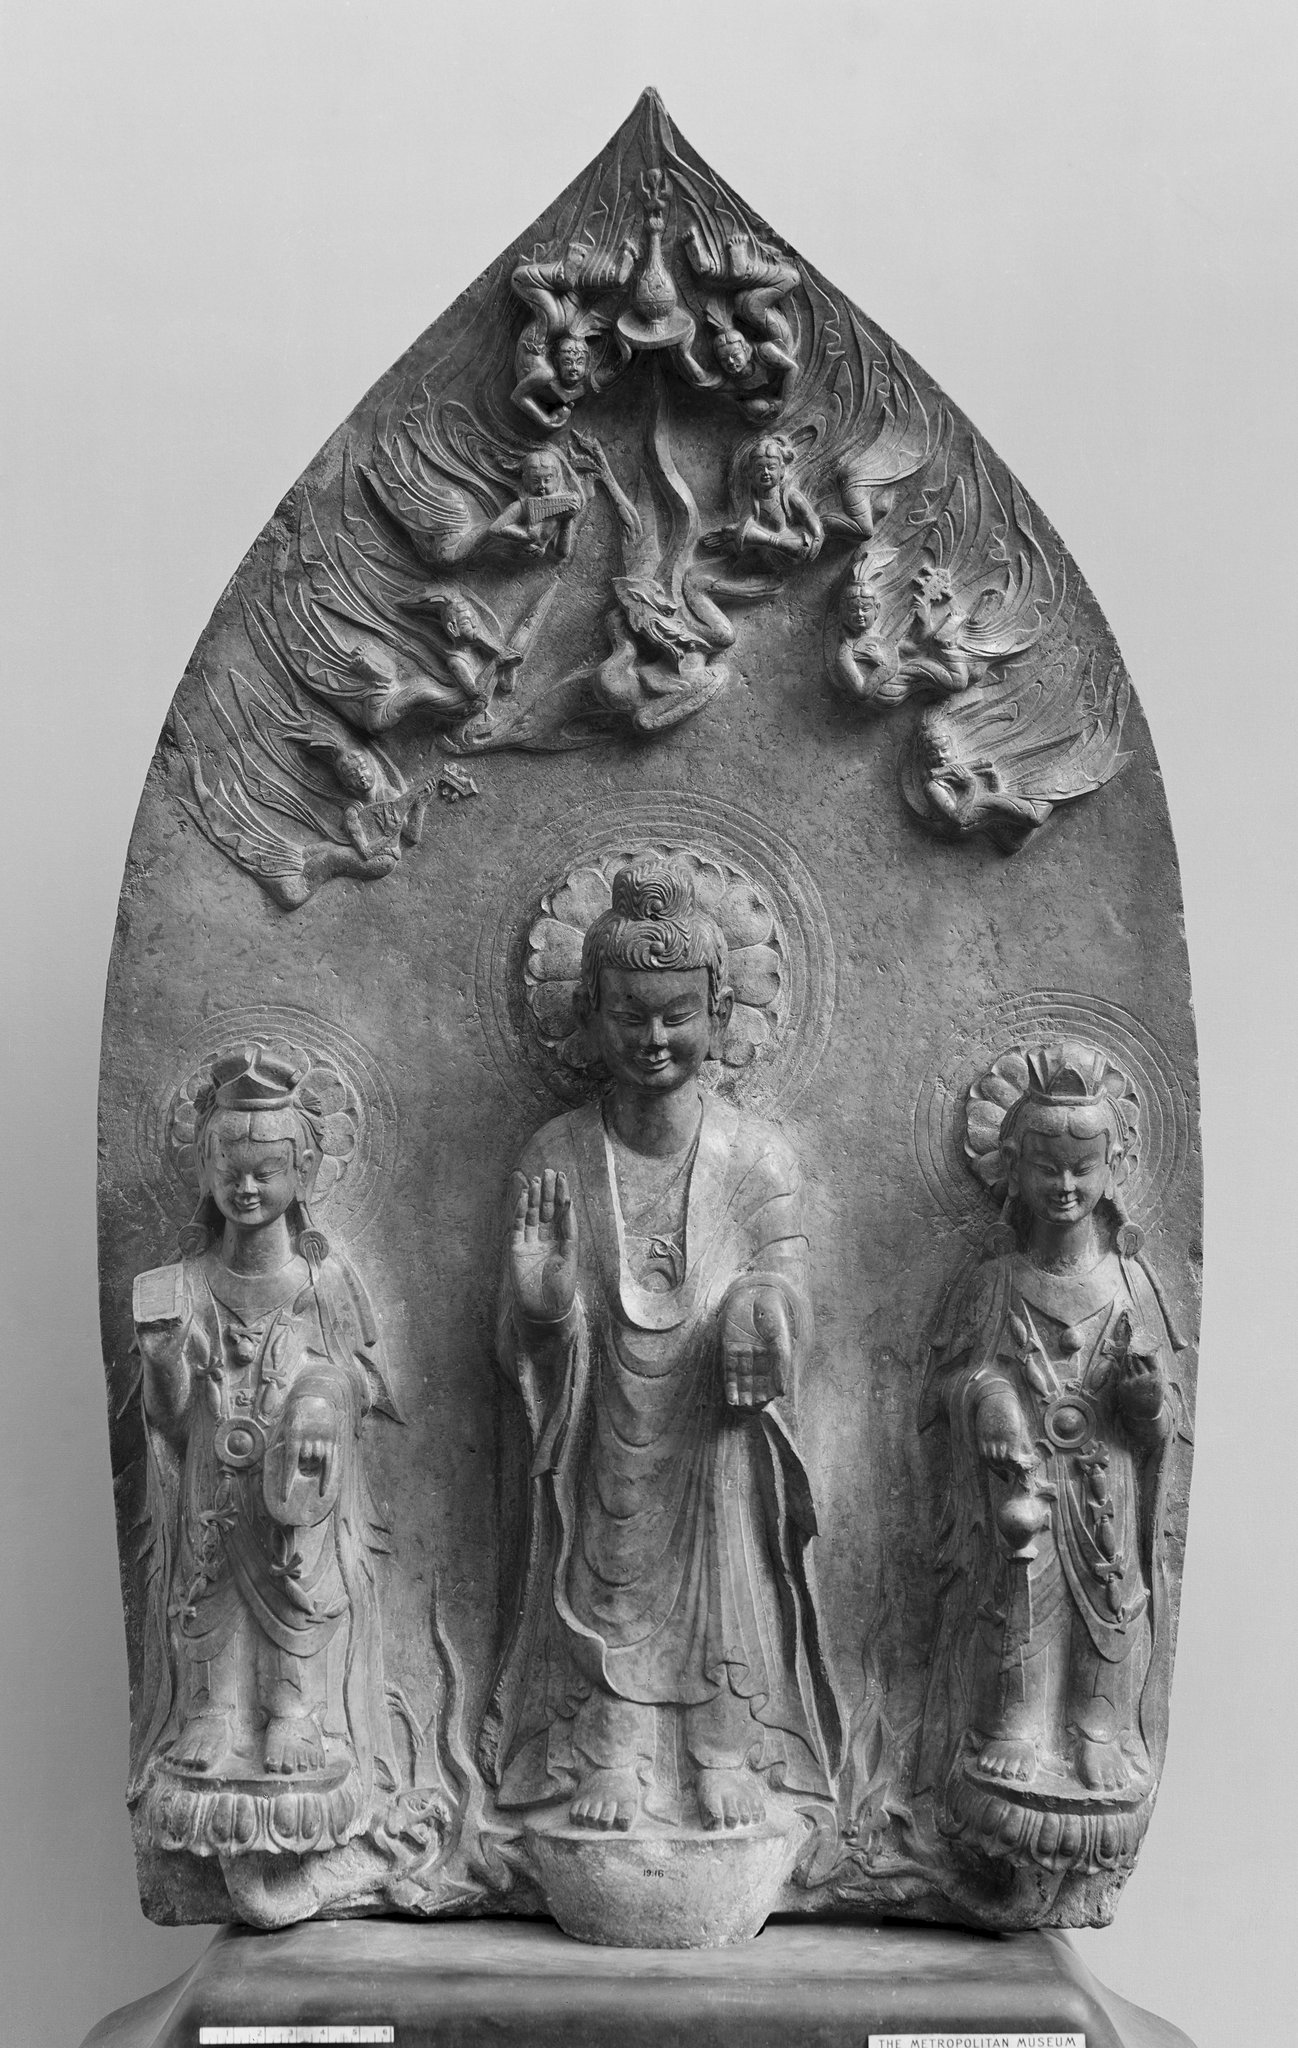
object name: stele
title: Stele with Maitreya and attendant bodhisattvas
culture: chinese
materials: stone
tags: buddha